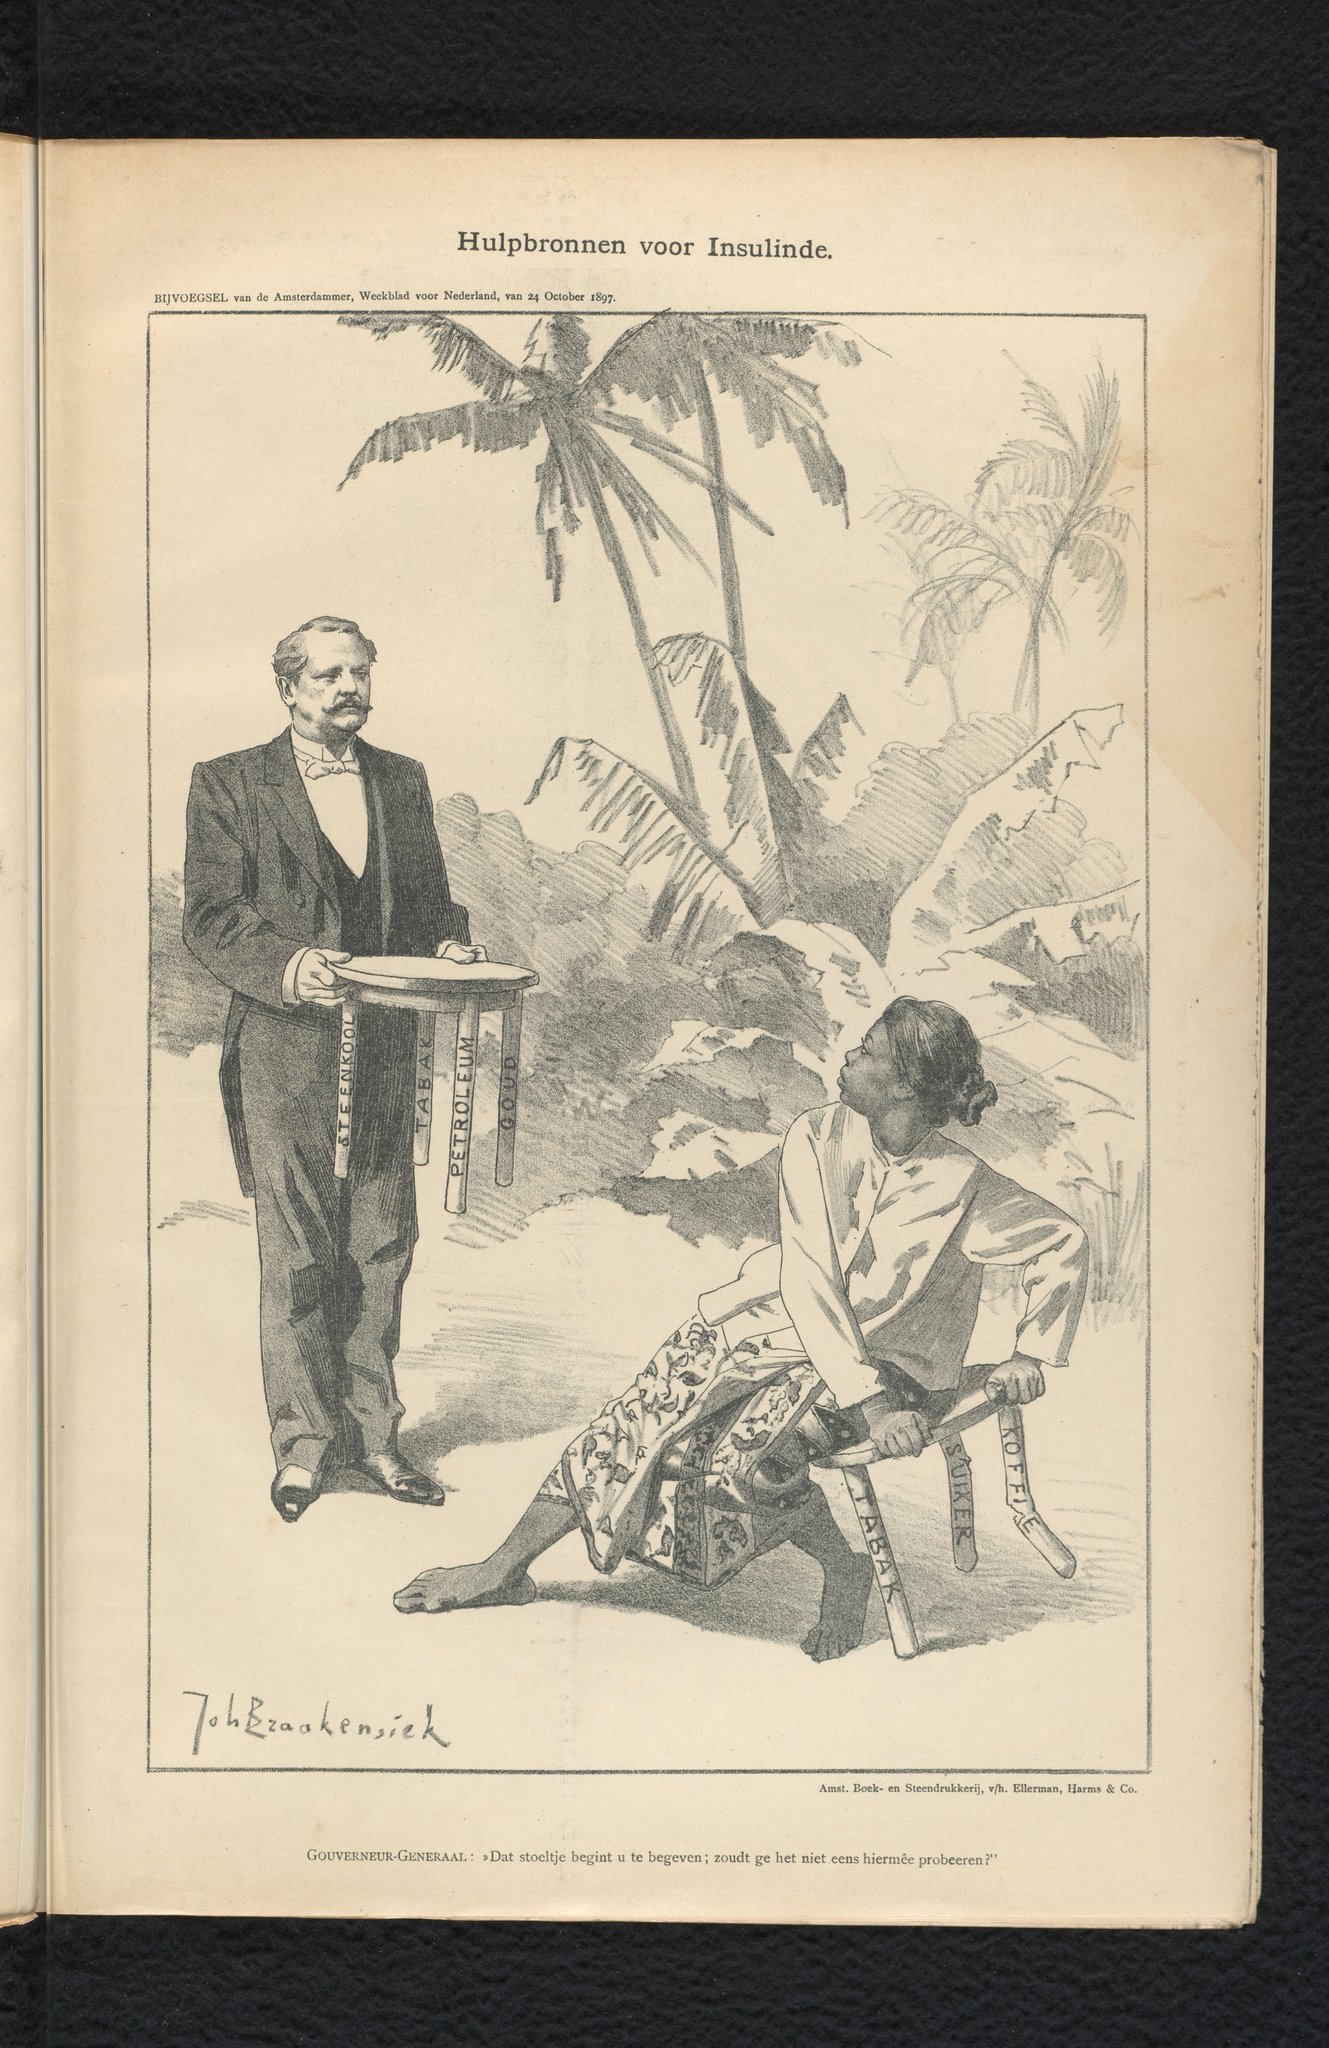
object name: cartoon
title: Hulpbronnen voor Insulinde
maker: johan braakensiek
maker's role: draughtsman, print maker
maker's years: 1858-1940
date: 1897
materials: paper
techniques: lithograph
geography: amsterdam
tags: colonial governor, personifications of countries, nations, states, districts, etc., political caricatures and satires, dutch east indies, the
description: Gouverneur-generaal Van der Wijck met een nieuwe sterkere stoel voor Nederlands-Indië.